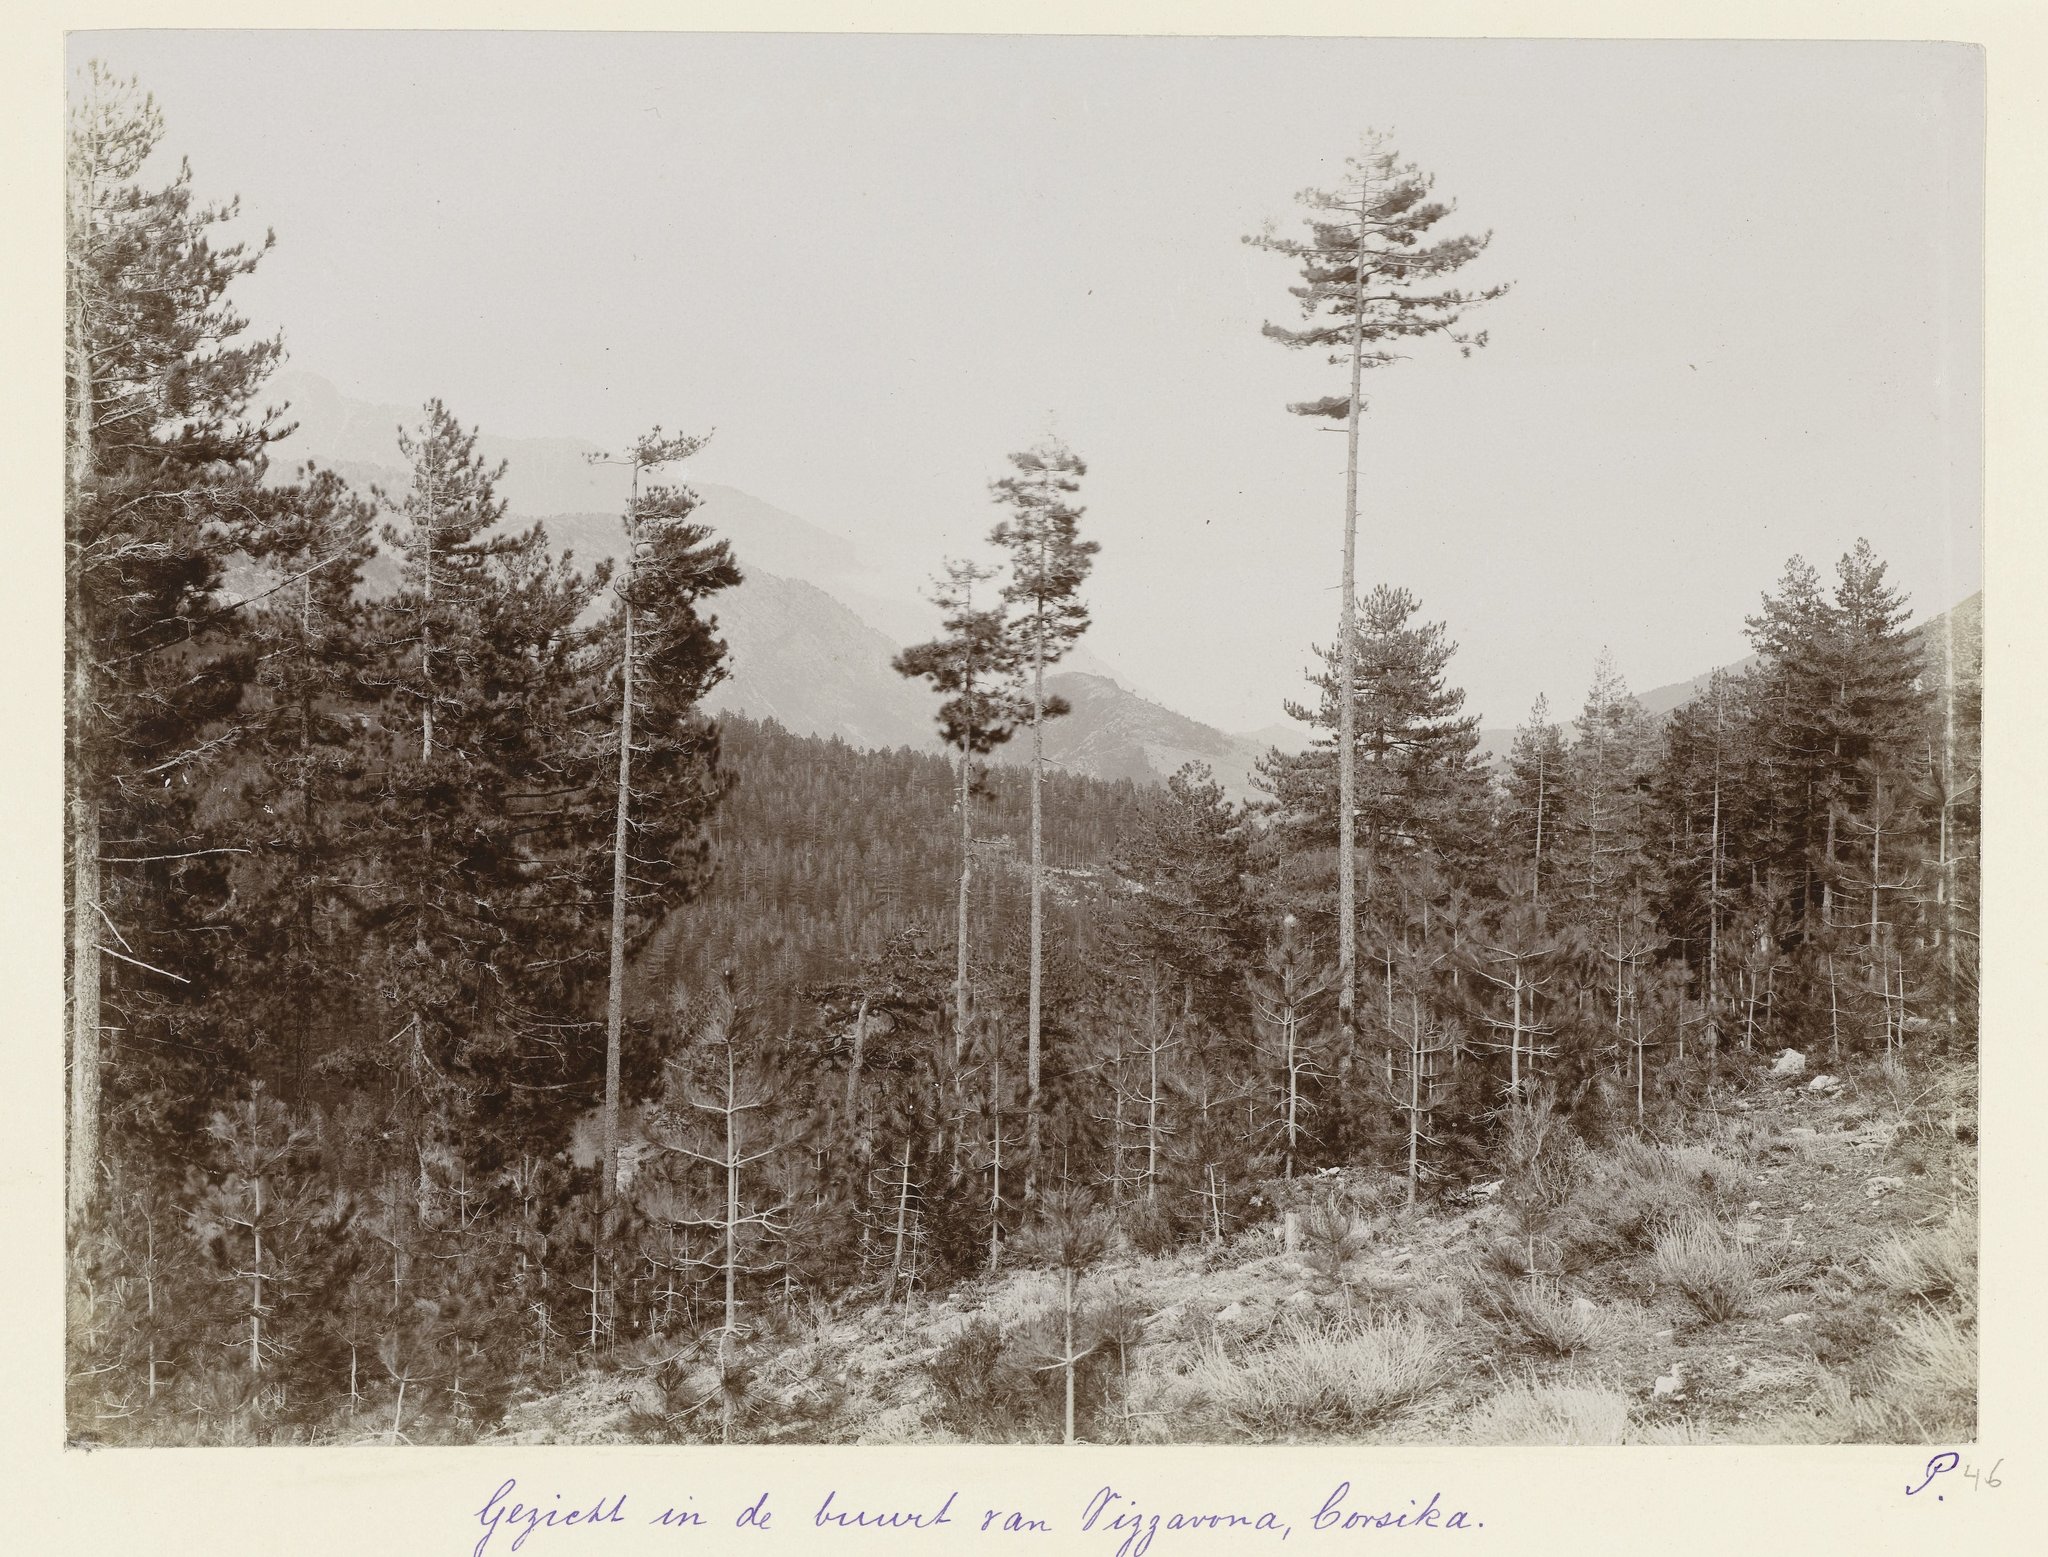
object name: photograph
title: Naaldbomen bos op Corsica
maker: henry pauw van wieldrecht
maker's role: fotograaf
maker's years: 1863-1912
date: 1886-1896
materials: cardboard, photographic support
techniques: albumen print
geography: corsica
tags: corsica